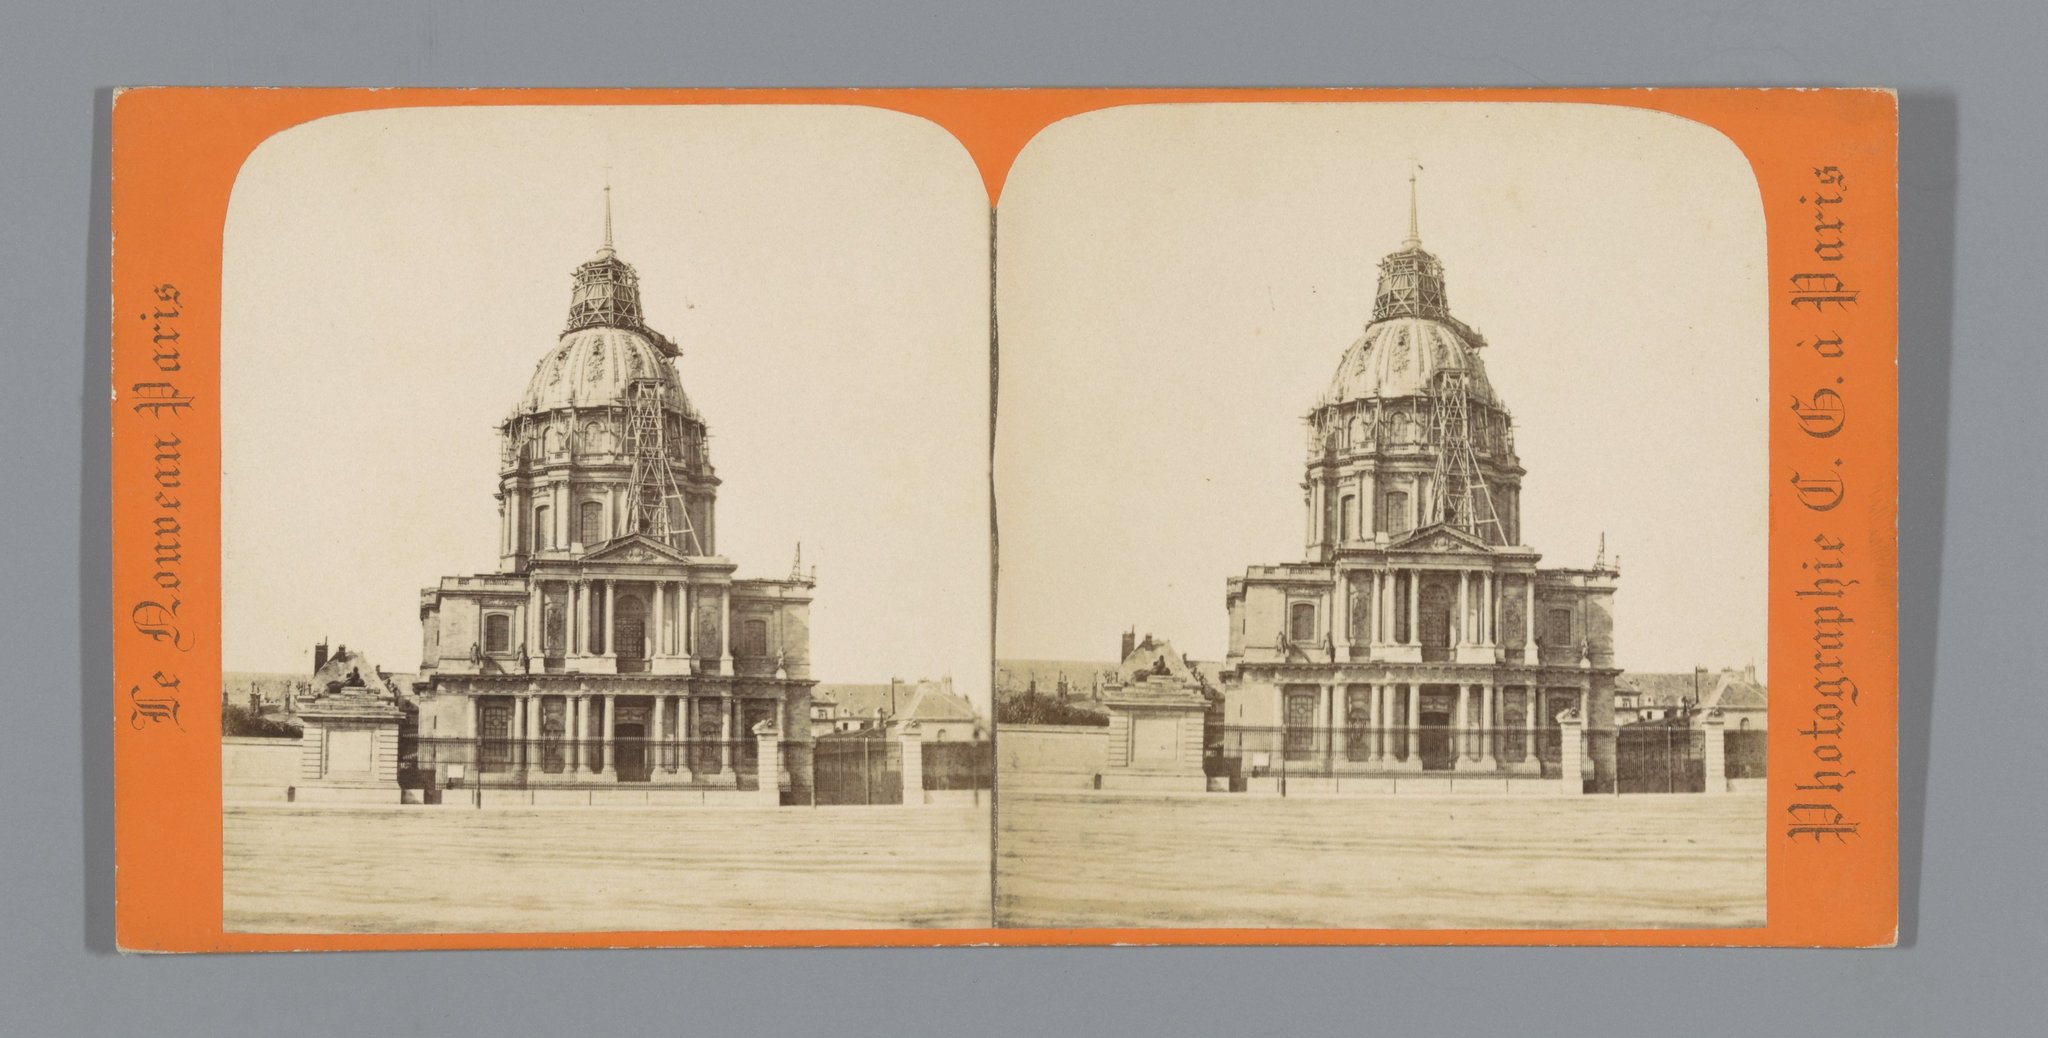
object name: stereograph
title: Gezicht op de Dôme des Invalides te Parijs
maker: charles gérard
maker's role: fotograaf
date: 1850-1875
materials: cardboard, photographic support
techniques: albumen print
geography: paris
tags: church (exterior), dome ~ architecture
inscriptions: inscription: ‘Dome des Invalides’